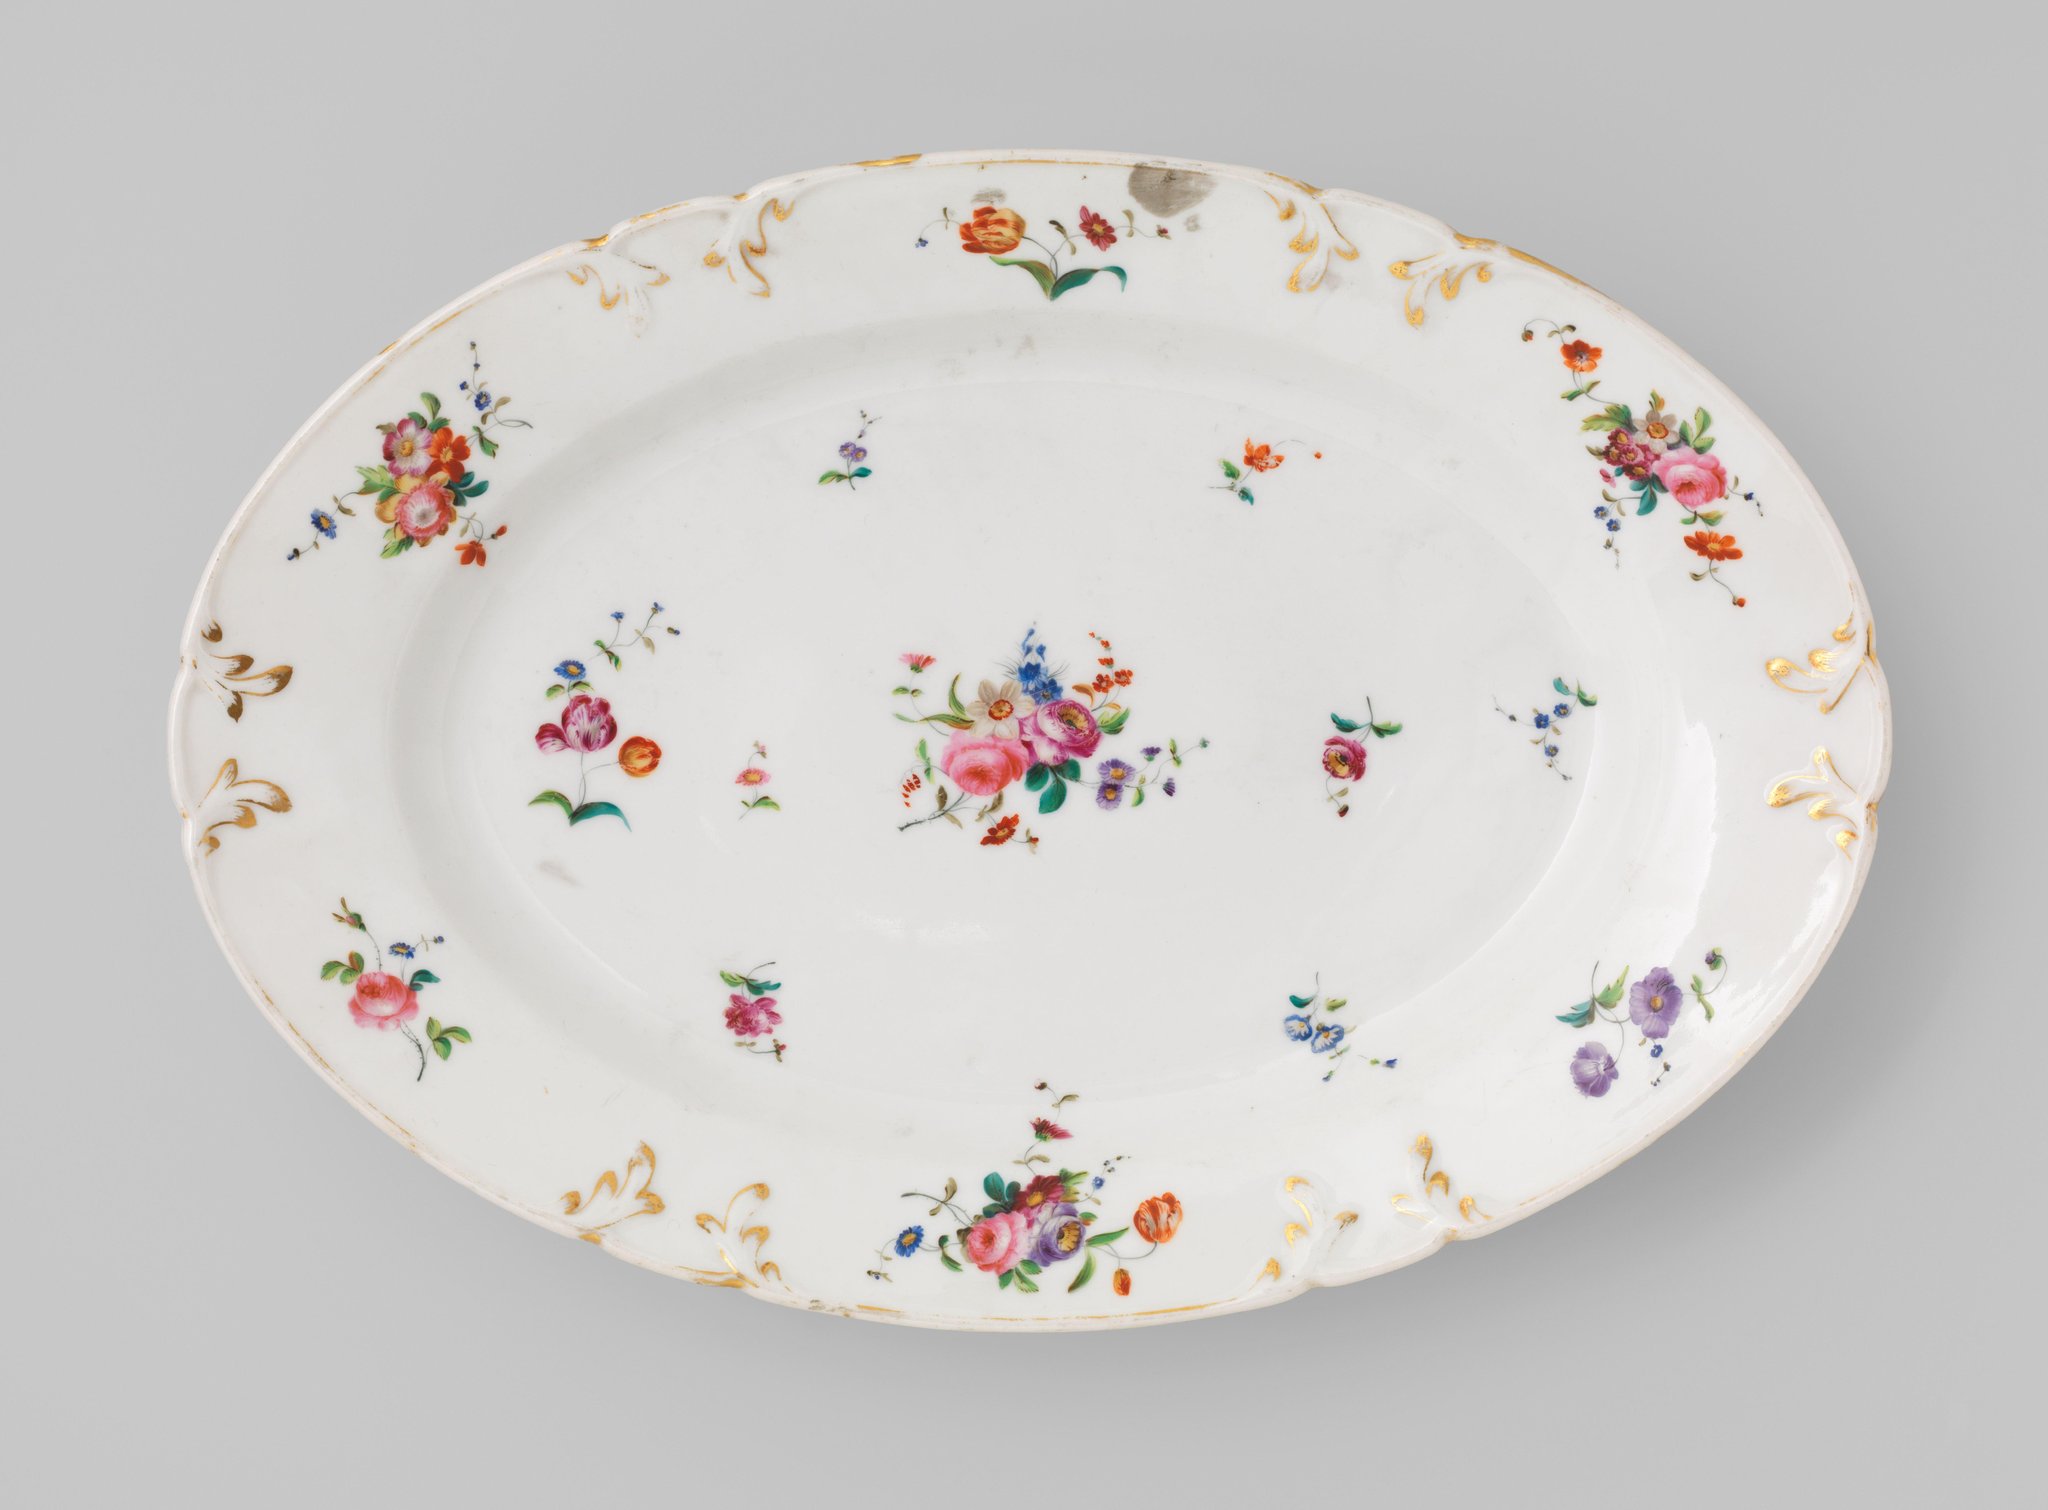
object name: platter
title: Dish with bouquets and flower sprays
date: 1839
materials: glaze, gold, paint, porcelain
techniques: firing, forming, gilding, turning, vitrification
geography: paris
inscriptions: mark: ‘DENUELLE/ Boulevard St. Denis 18/ à Paris’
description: Ovale schotel van porselein met een gelobde rand, beschilderd op het glazuur in blauw, rood, roze, groen, geel, paars, zwart en goud. Op het plat boeketten van verschillende bloemen en strooibloemen. Vanuit de gelobde, gouden rand, gemodelleerde bladranken in reliëf, aangezet met goud. Hiertussen boeketten. Dubbele voetring. Gemerkt op de onderzijde met 'DENUELLE/ Boulevard St. Denis 18/ à Paris'.